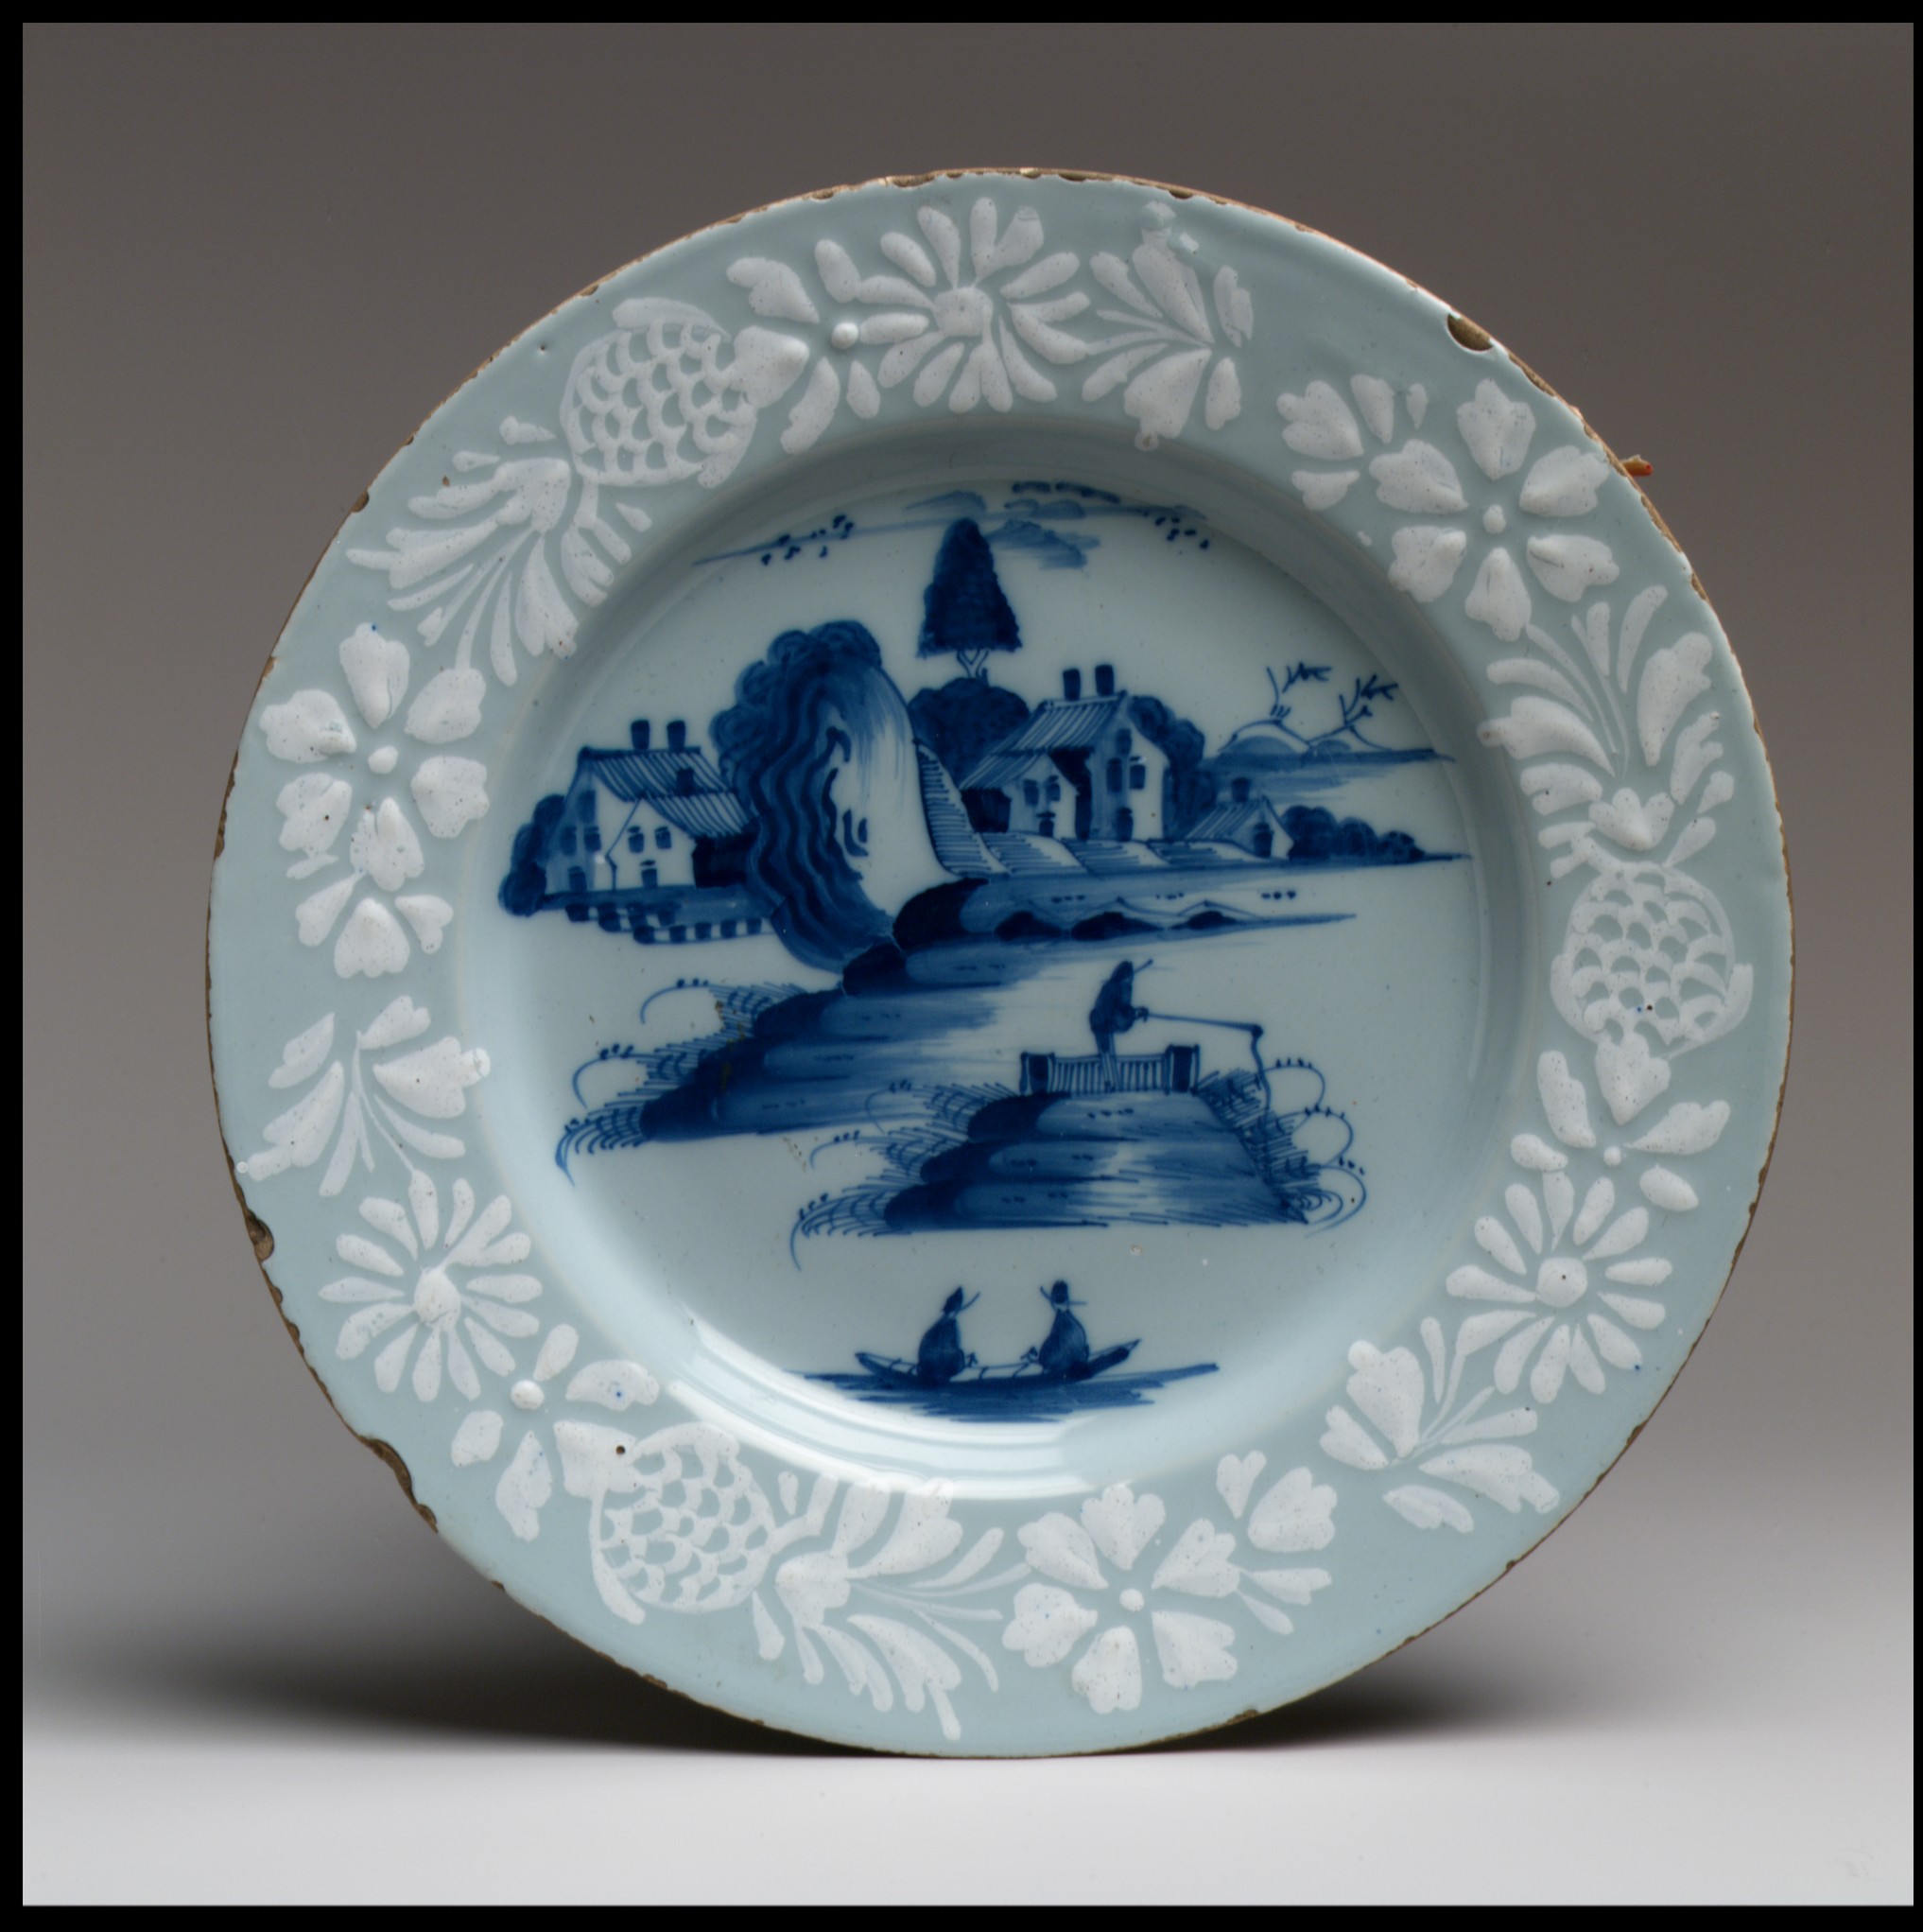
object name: plate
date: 1760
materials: earthenware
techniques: glazing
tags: houses,flowers